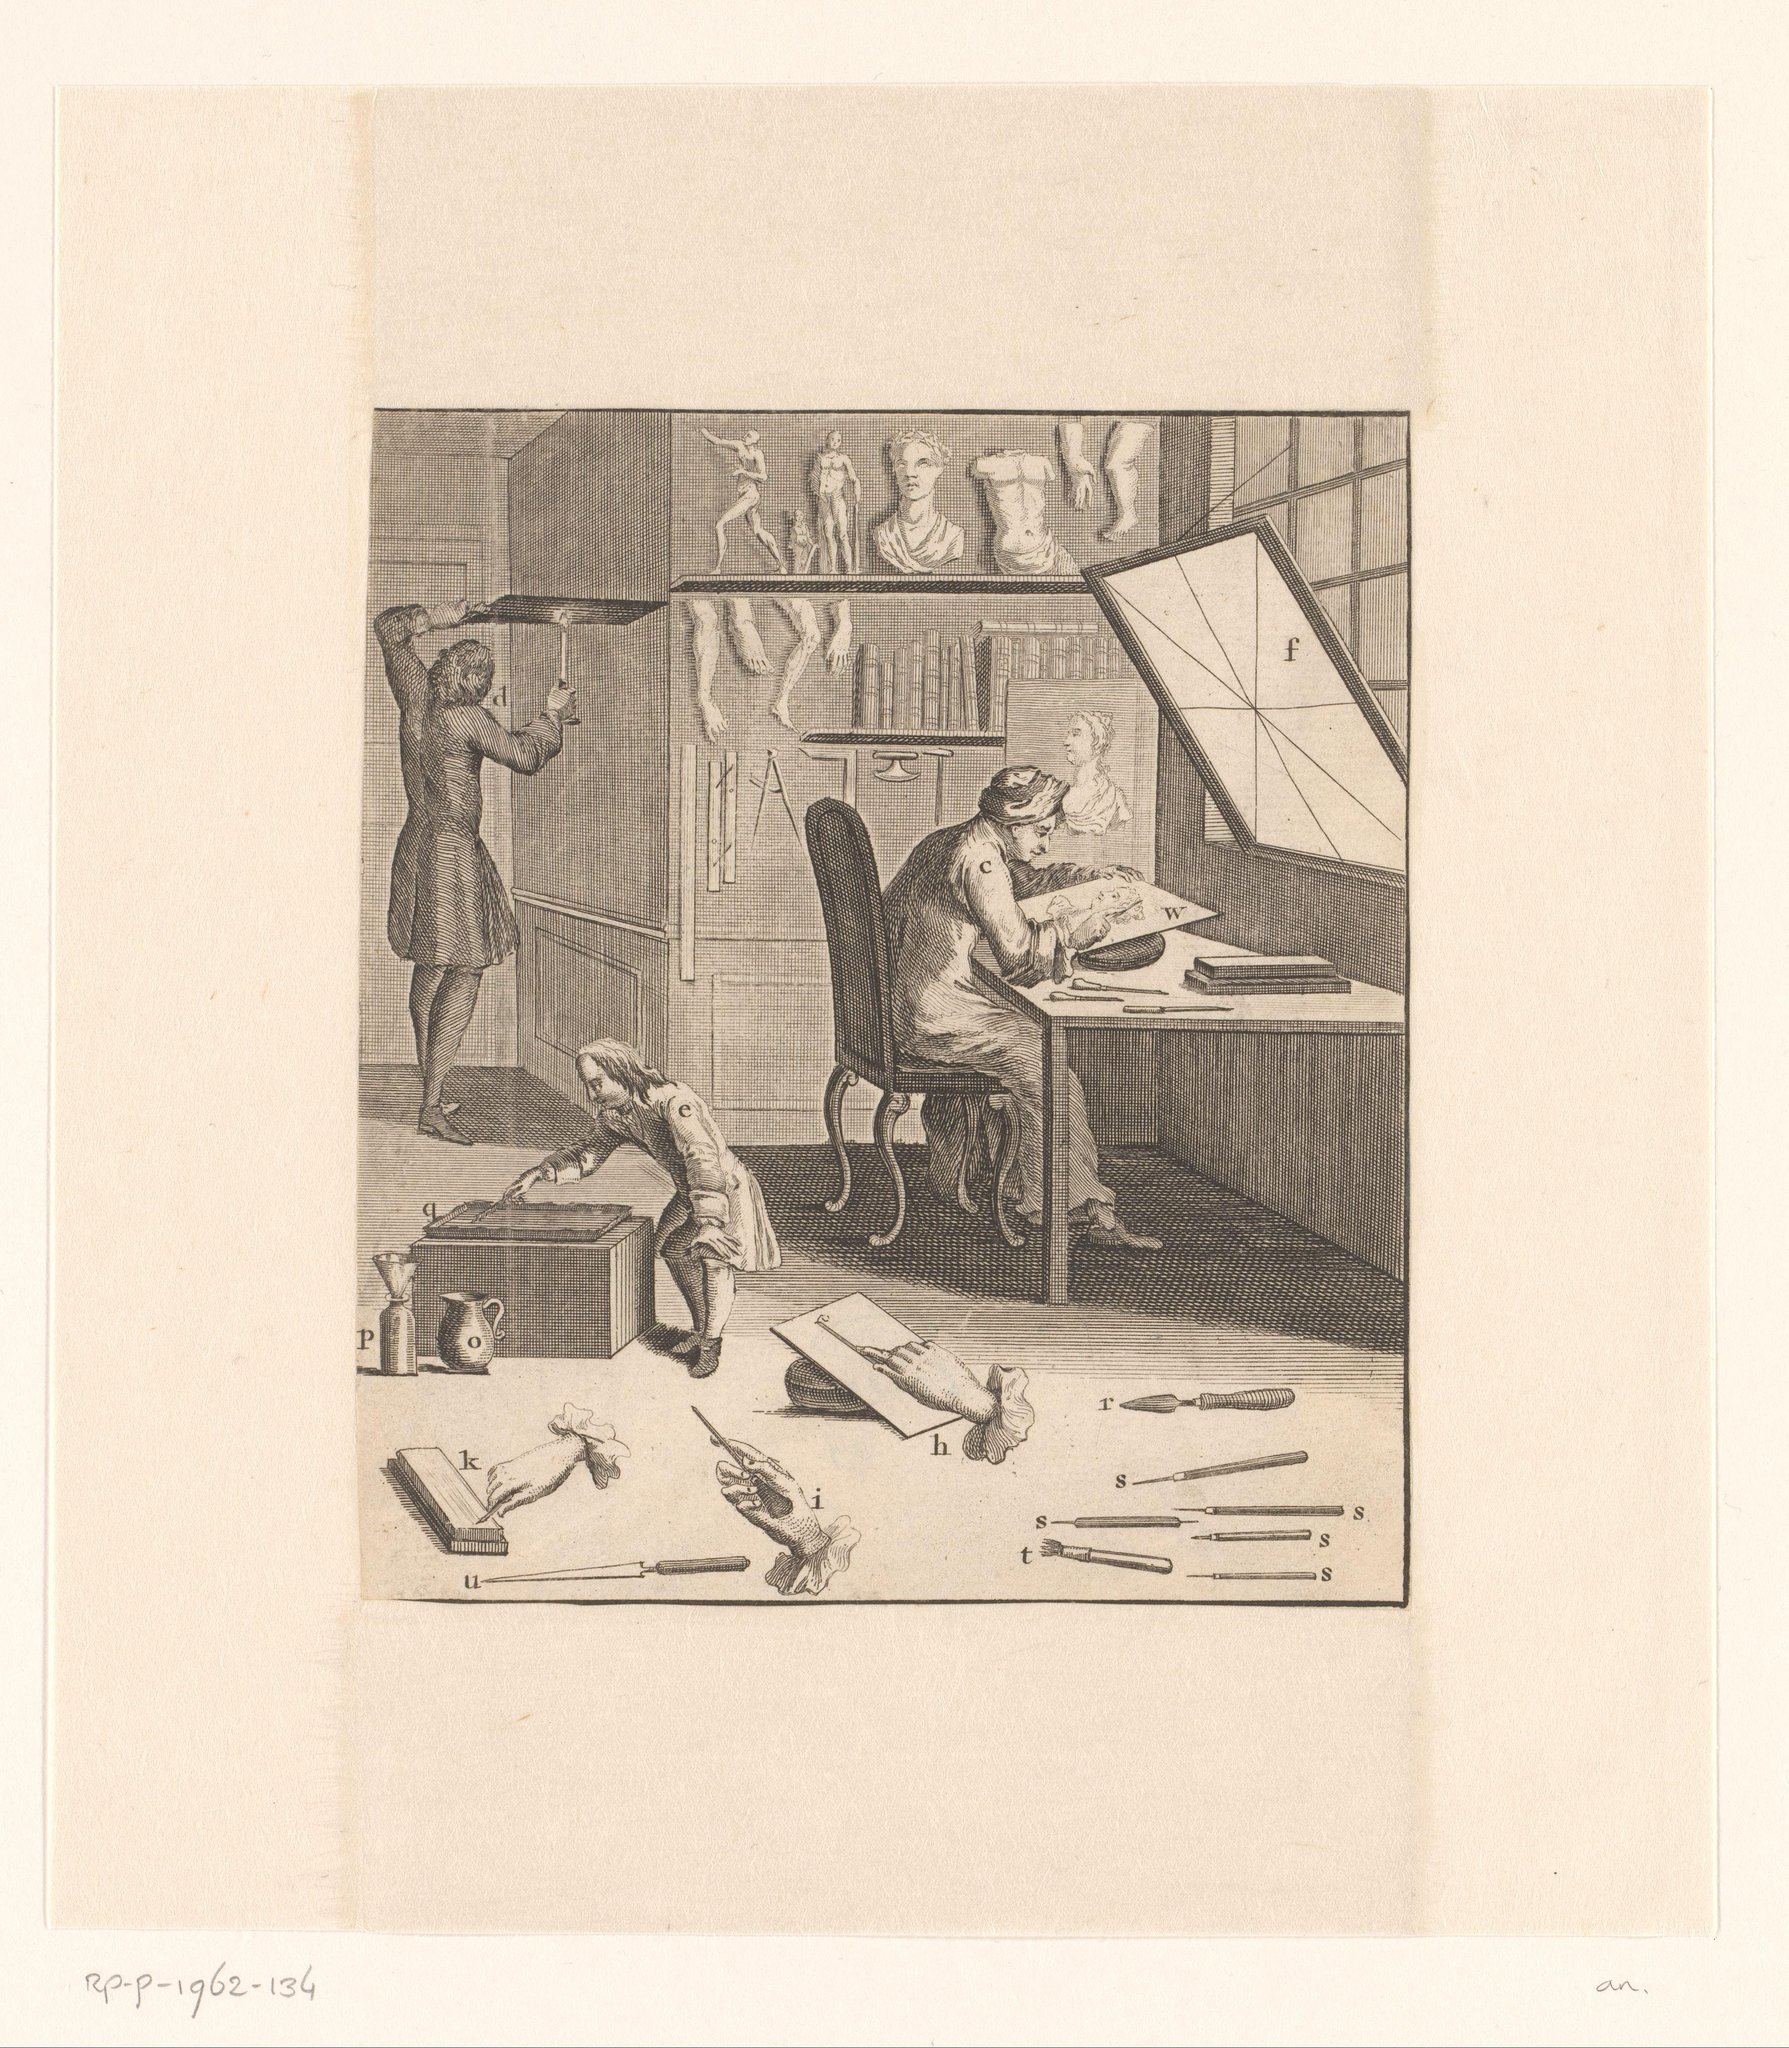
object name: print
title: Atelier van een prentmaker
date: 1748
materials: paper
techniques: etching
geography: london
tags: tools, implements of graphic artist, workshop, studio of the artist (in general), engraver, etcher (+ artist at work)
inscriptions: collector's mark: Lugt 2228, collector's mark: Lugt 2760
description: Aan de tafel rechts zit een prentmaker te graveren bij open raam. Op de muur achter hem verschillende gipsmodellen. Links veegt een jongen met een kwast over een plaat die in een bad met zuur ligt te etsen. Linksboven een man die een etsplaat beroet met een kaars. Onderaan verschillende ets- en graveergereedschappen. De verschillende figuren en objecten zijn aangeduid met letters.